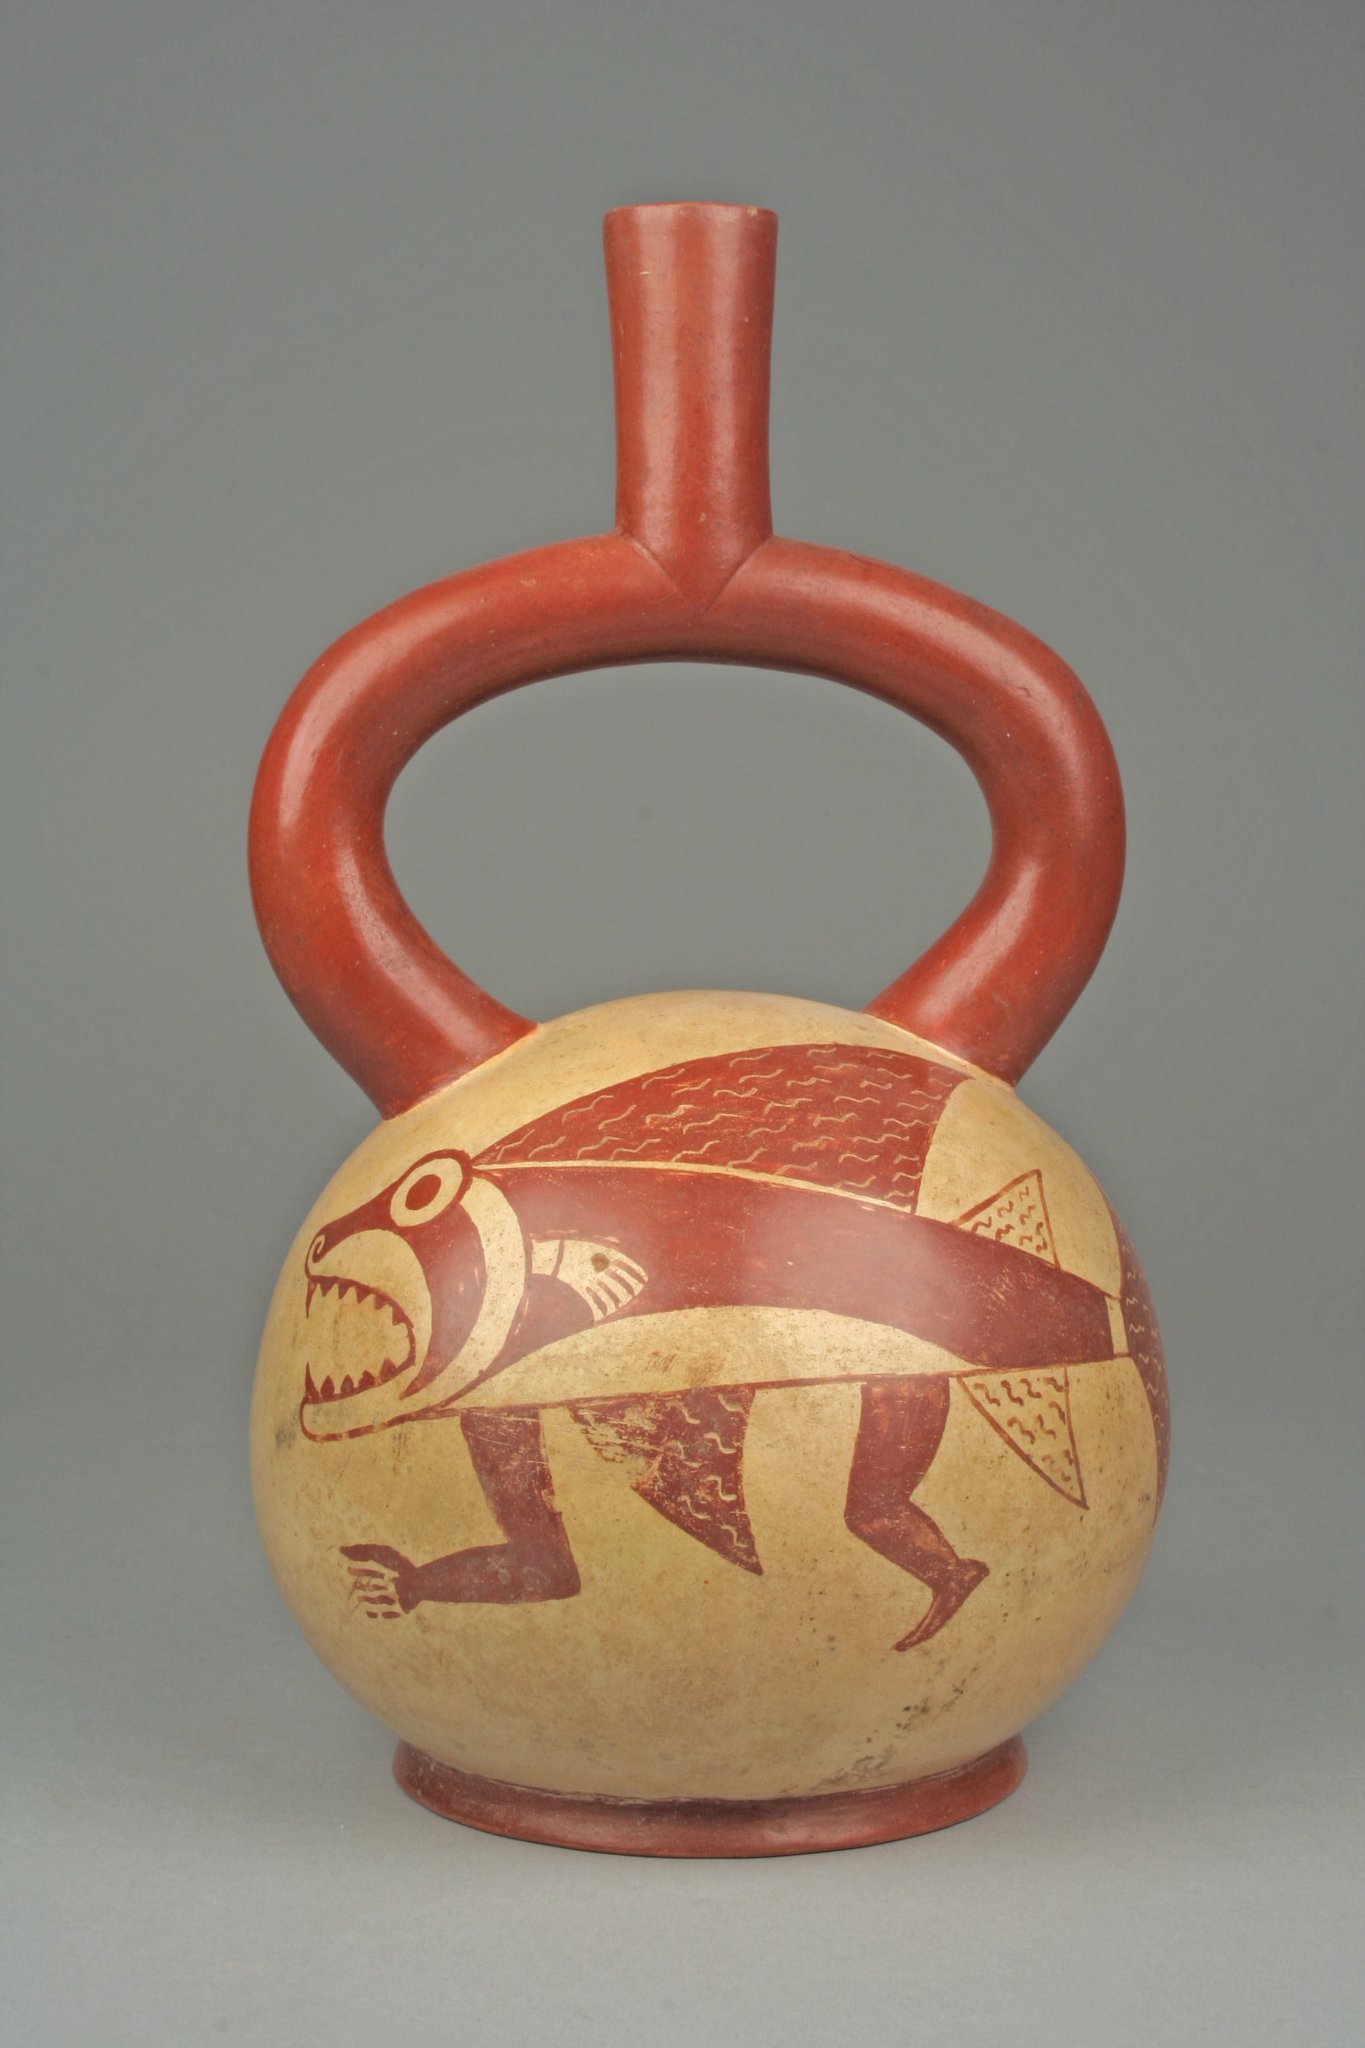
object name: bottle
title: Stirrup Spout Bottle with Sea Monster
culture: moche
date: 1-600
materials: ceramic, pigment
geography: peru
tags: monsters